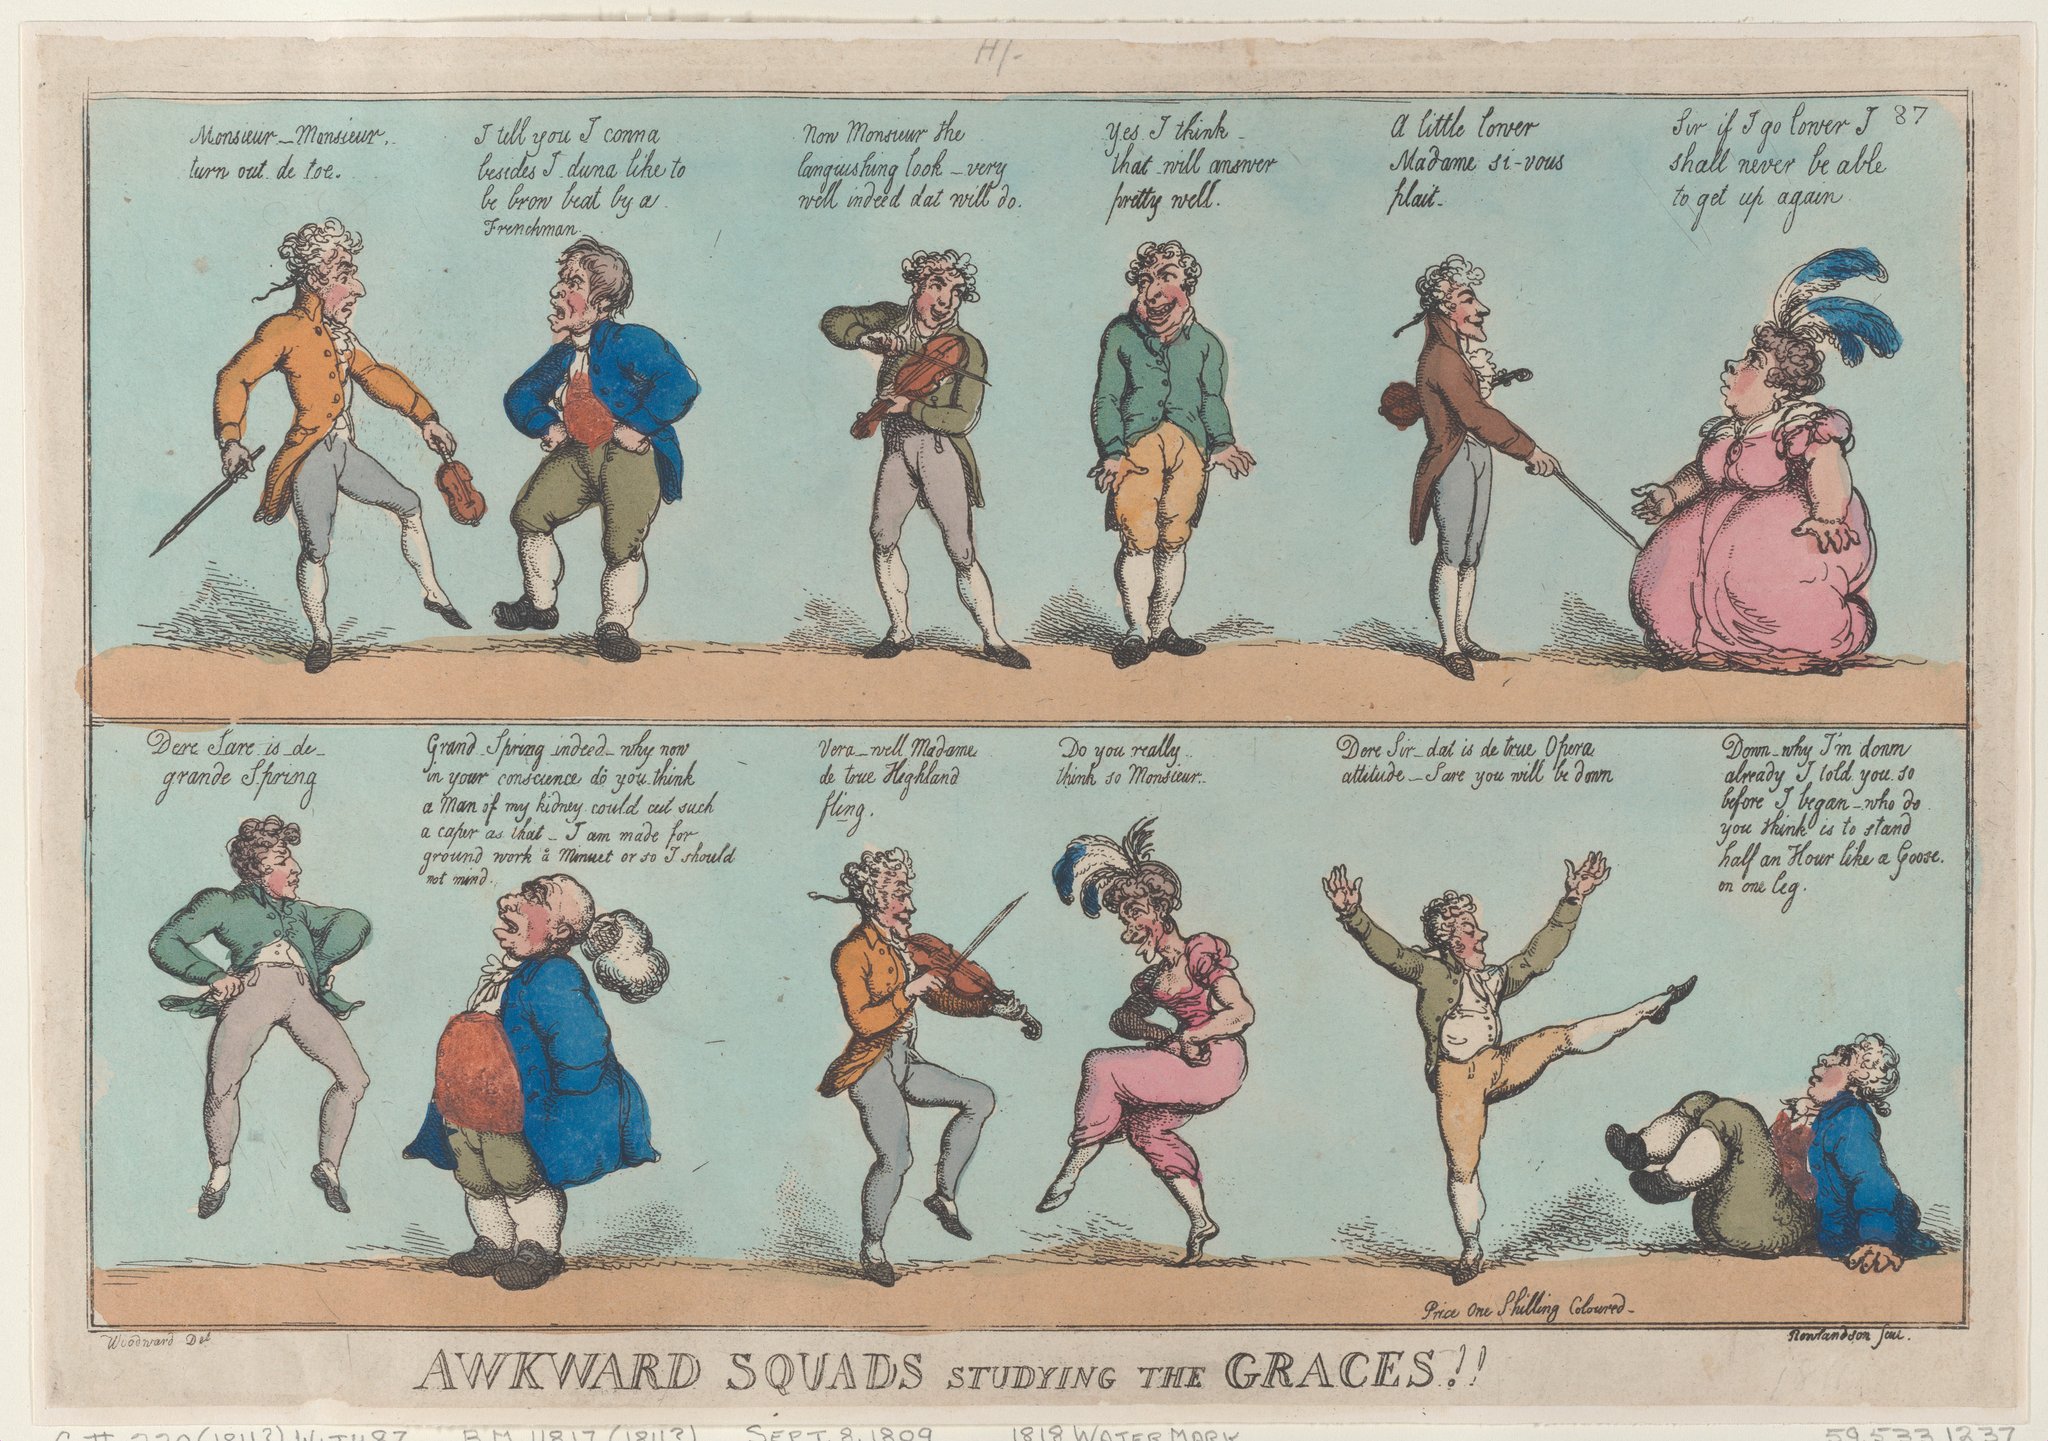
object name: print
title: Awkward Squads Studying the Graces!!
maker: thomas rowlandson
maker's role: artist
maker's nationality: british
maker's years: 1757-1827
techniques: etching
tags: satire,men,women